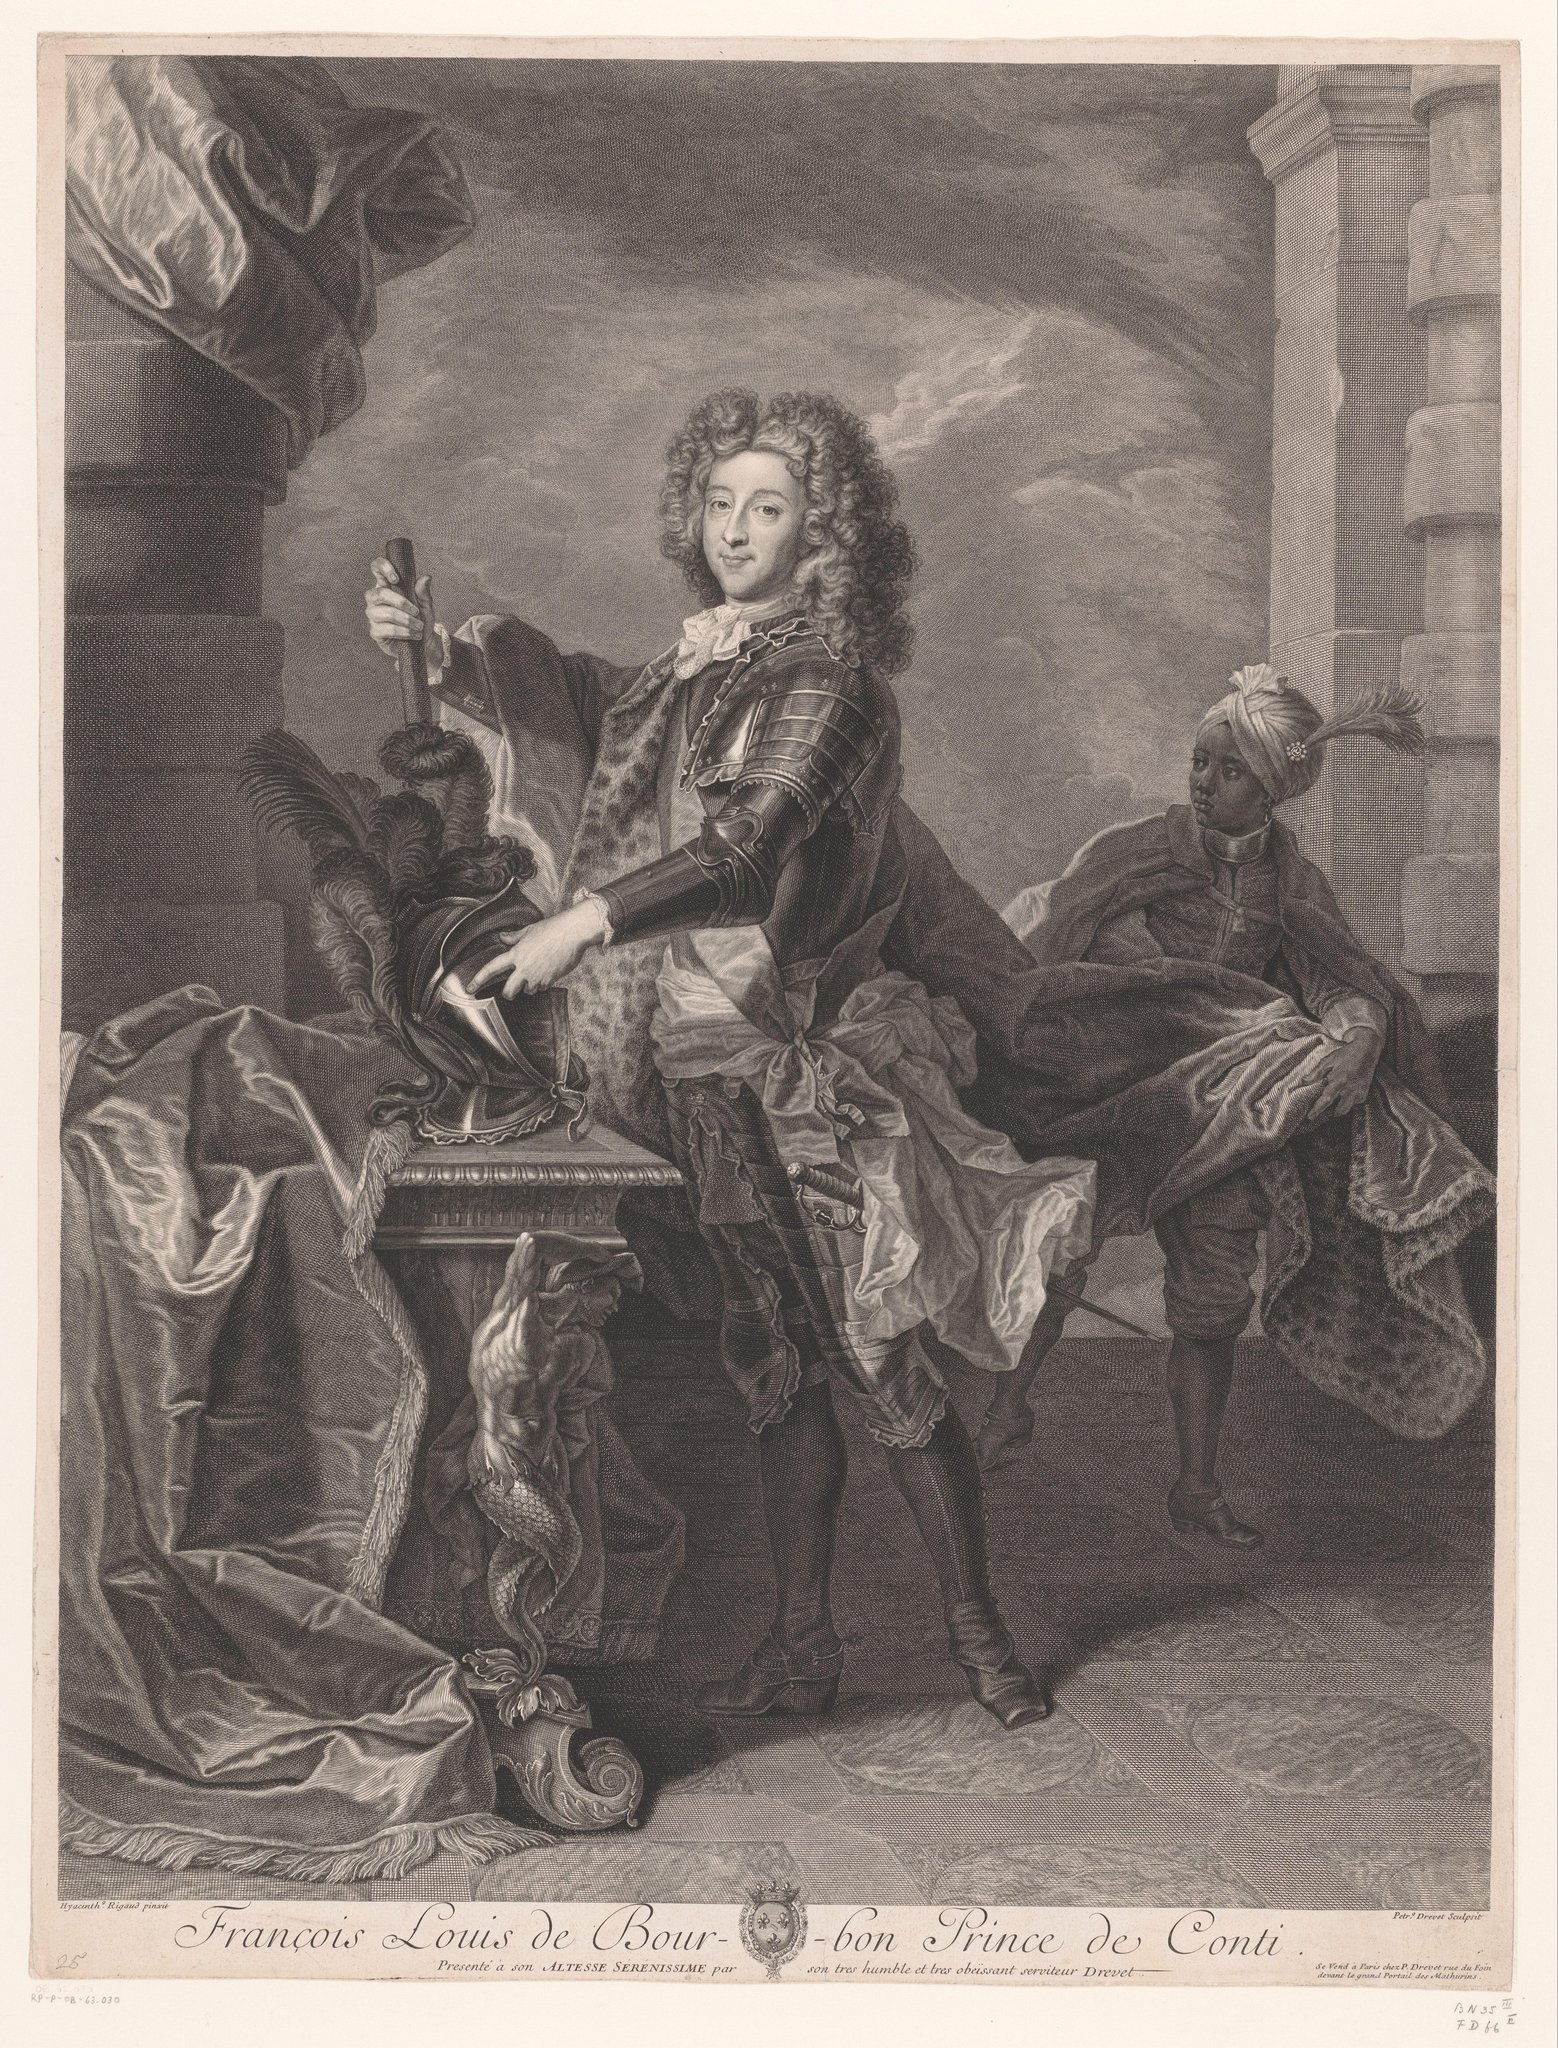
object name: print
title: Portret van Frans Lodewijk van Bourbon-Conti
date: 1700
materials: paper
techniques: engraving, etching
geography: paris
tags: paris, frans lodewijk de bourbon-conti, prince, historical persons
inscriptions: collector's mark: Lugt 240